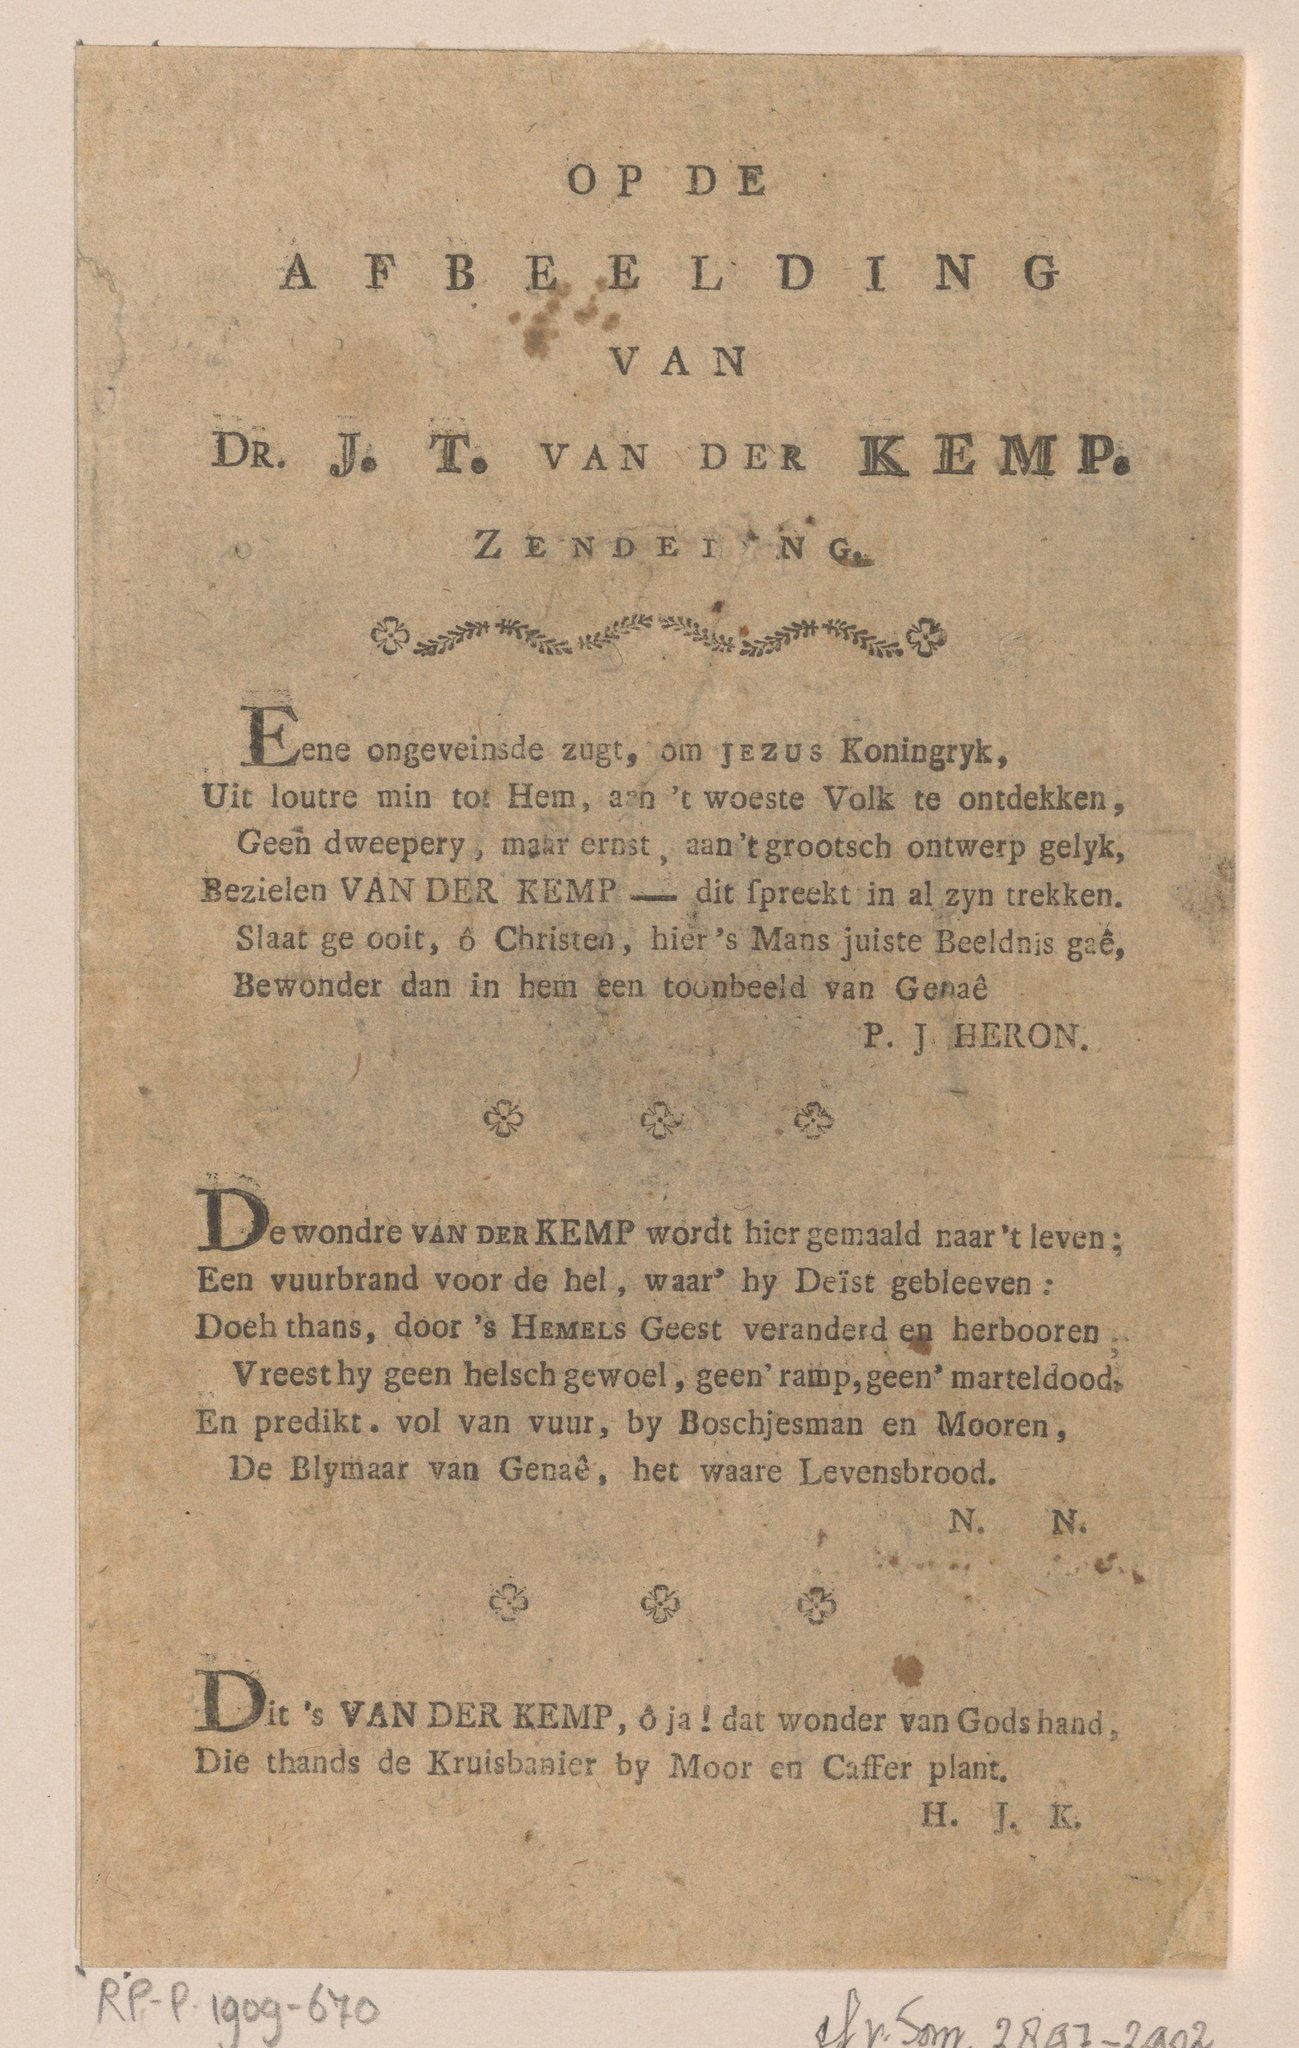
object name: text sheet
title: Gedichten op het portret van Johannes Theodorus van der Kemp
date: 1799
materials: paper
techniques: letterpress printing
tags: rotterdam, historical persons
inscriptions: collector's mark: Lugt 2228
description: Tekstblad mogelijk uit: Evangelical Magazine (1799).